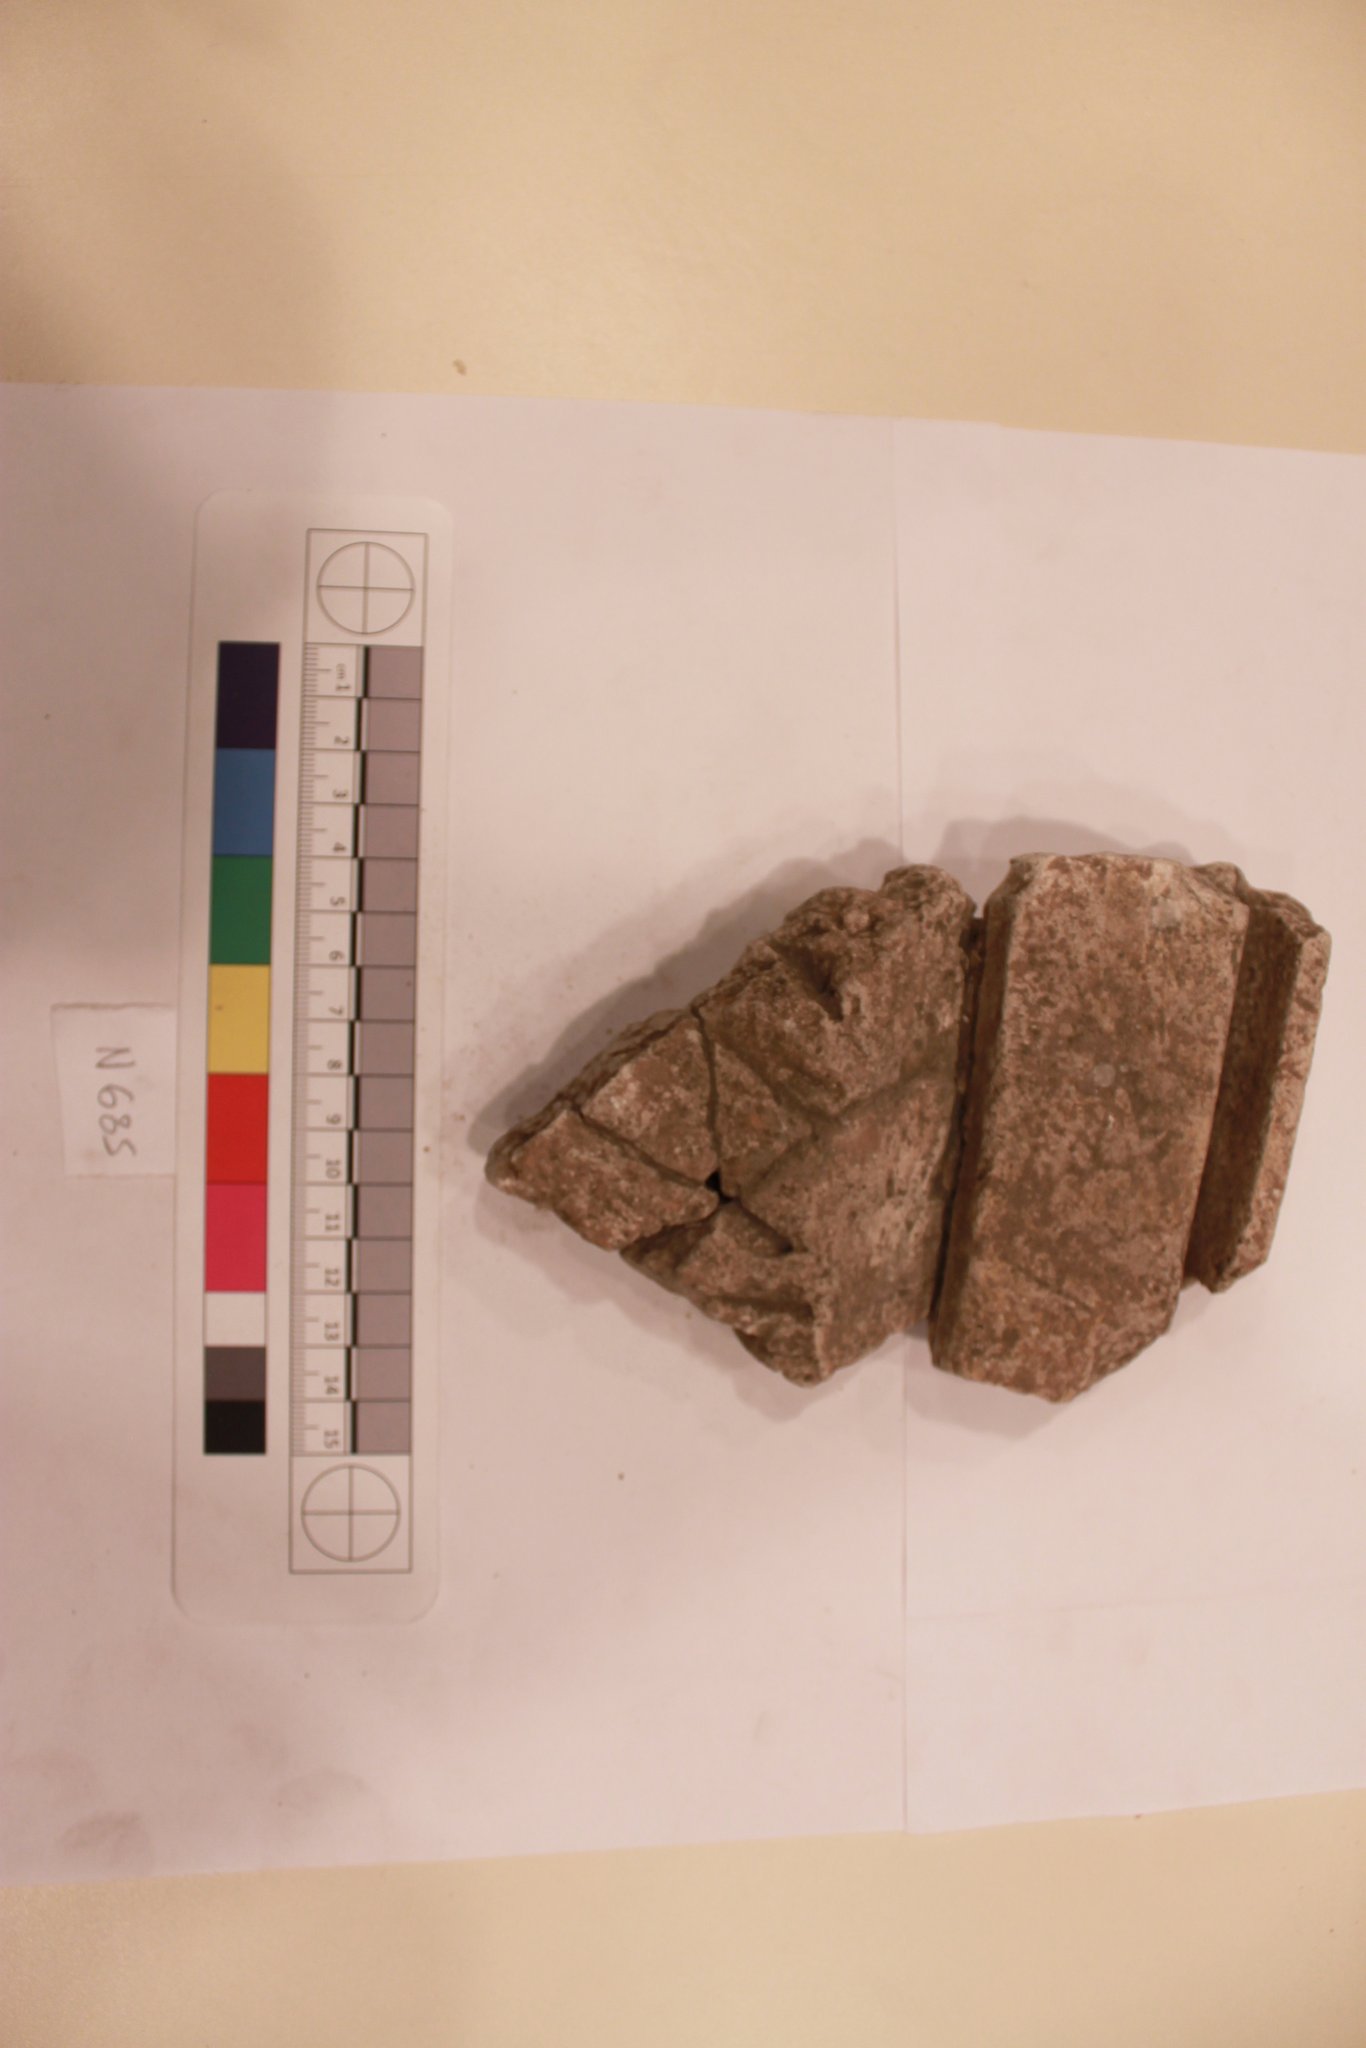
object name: fragment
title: Stucco Fragment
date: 701-1200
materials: plaster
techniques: carving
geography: iran